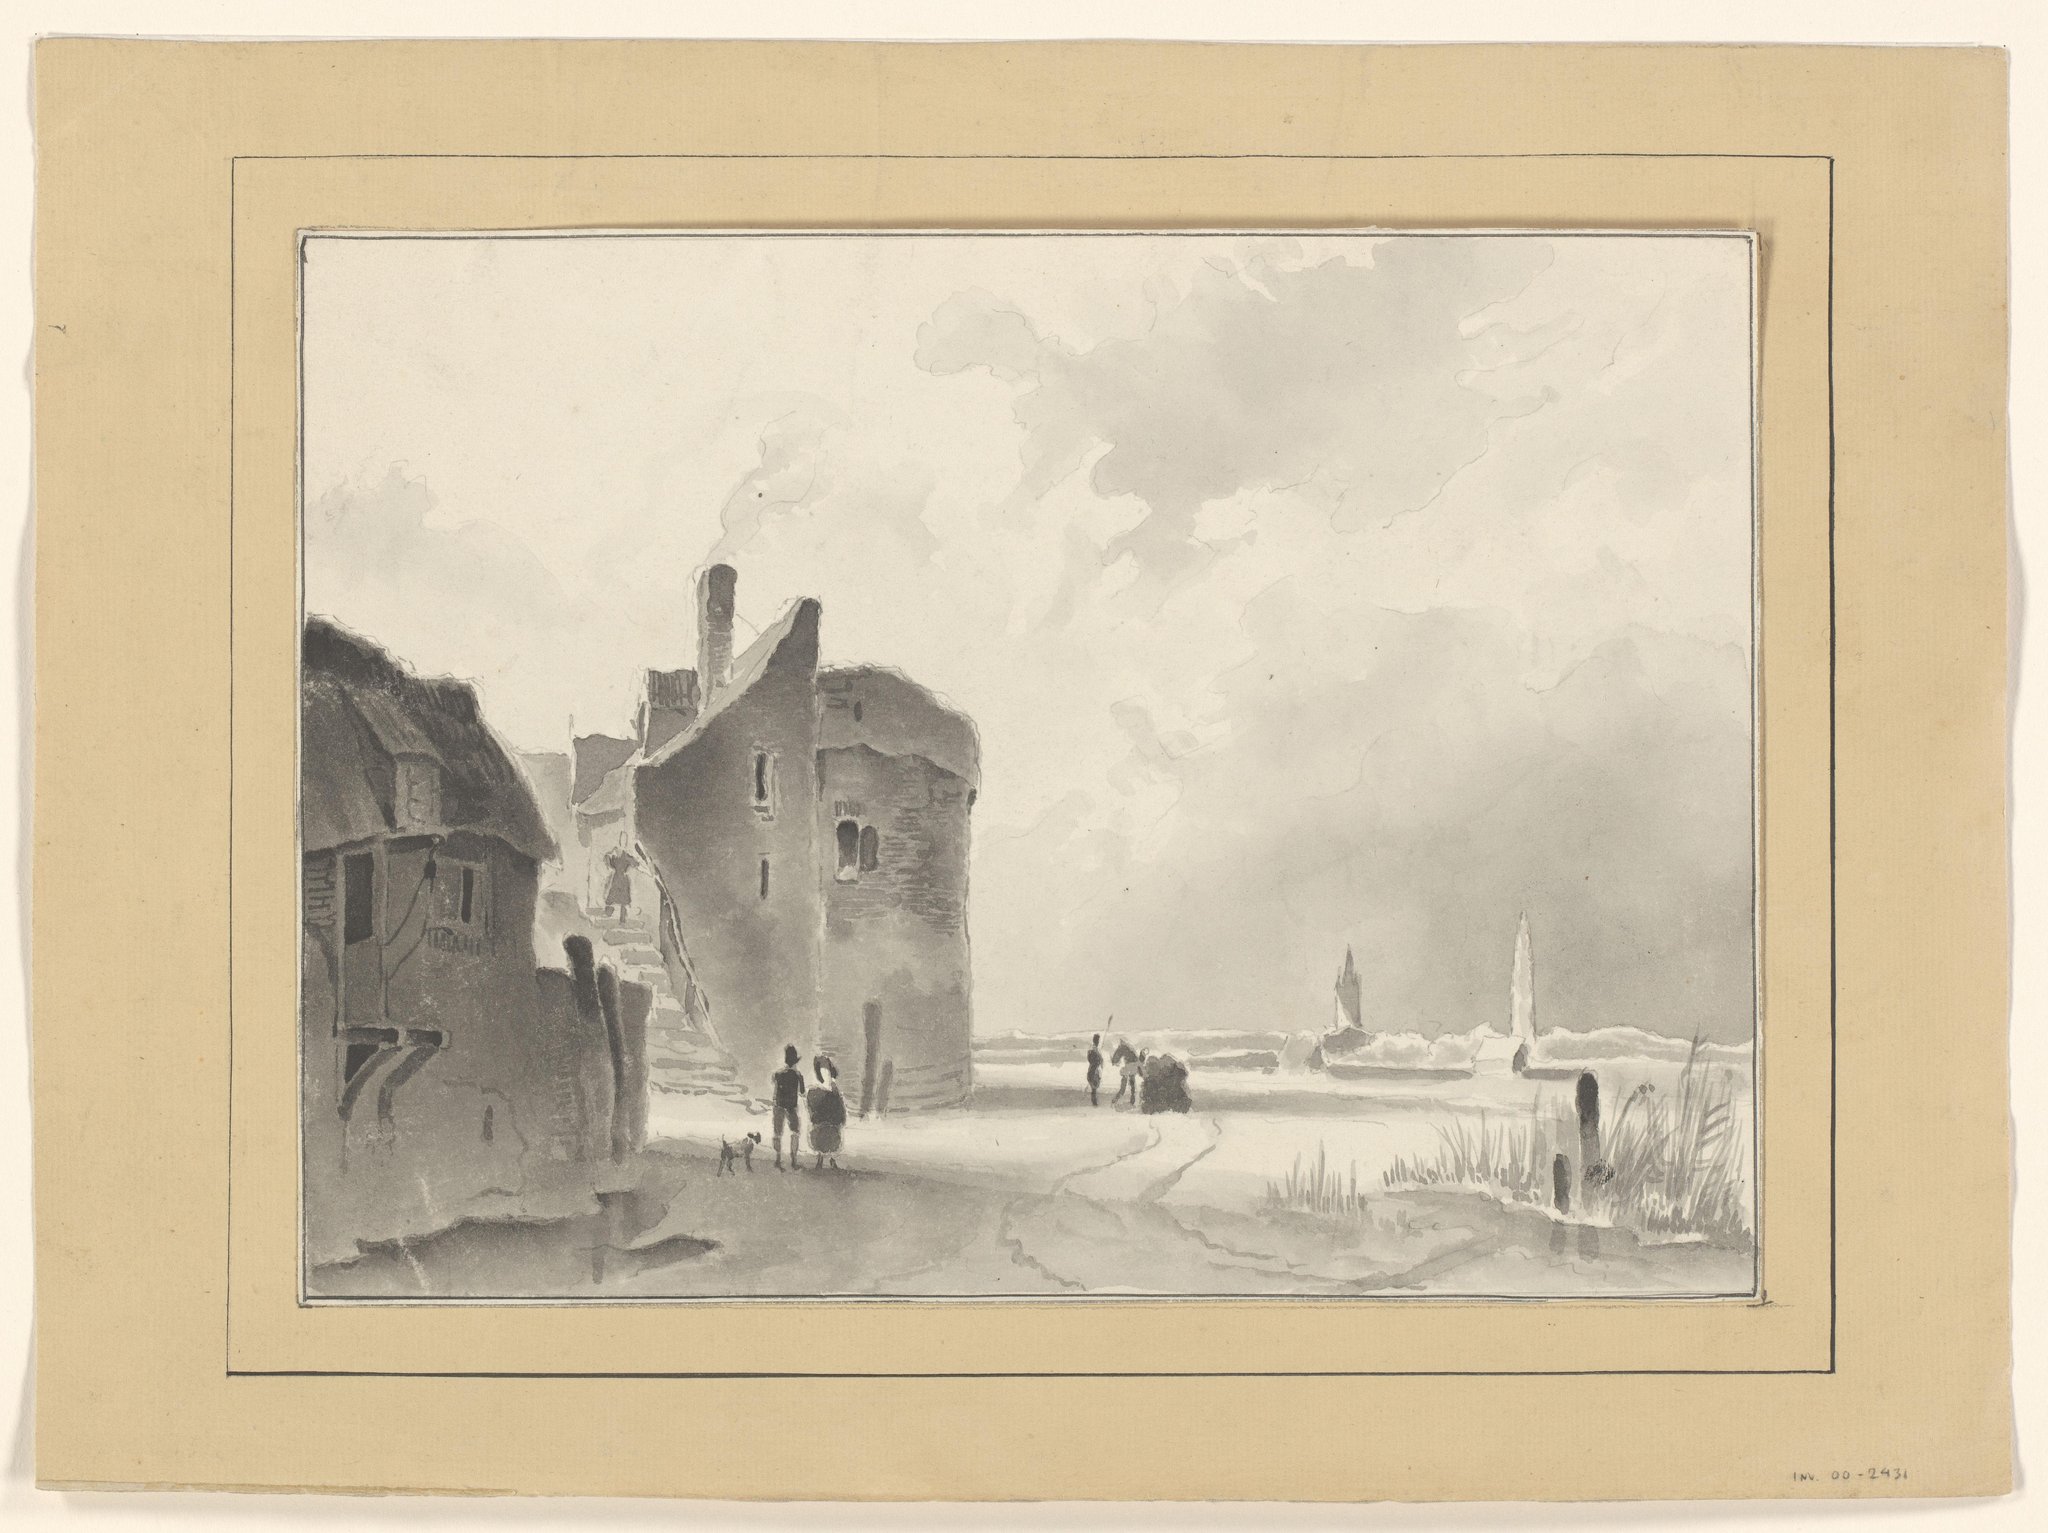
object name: drawing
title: Winterlandschap met toren en figuren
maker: johannes van reijn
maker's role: draughtsman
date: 1800-1900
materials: paper, pencil, watercolor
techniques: brush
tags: winter, 'hyems'; 'inverno' (ripa), city-walls